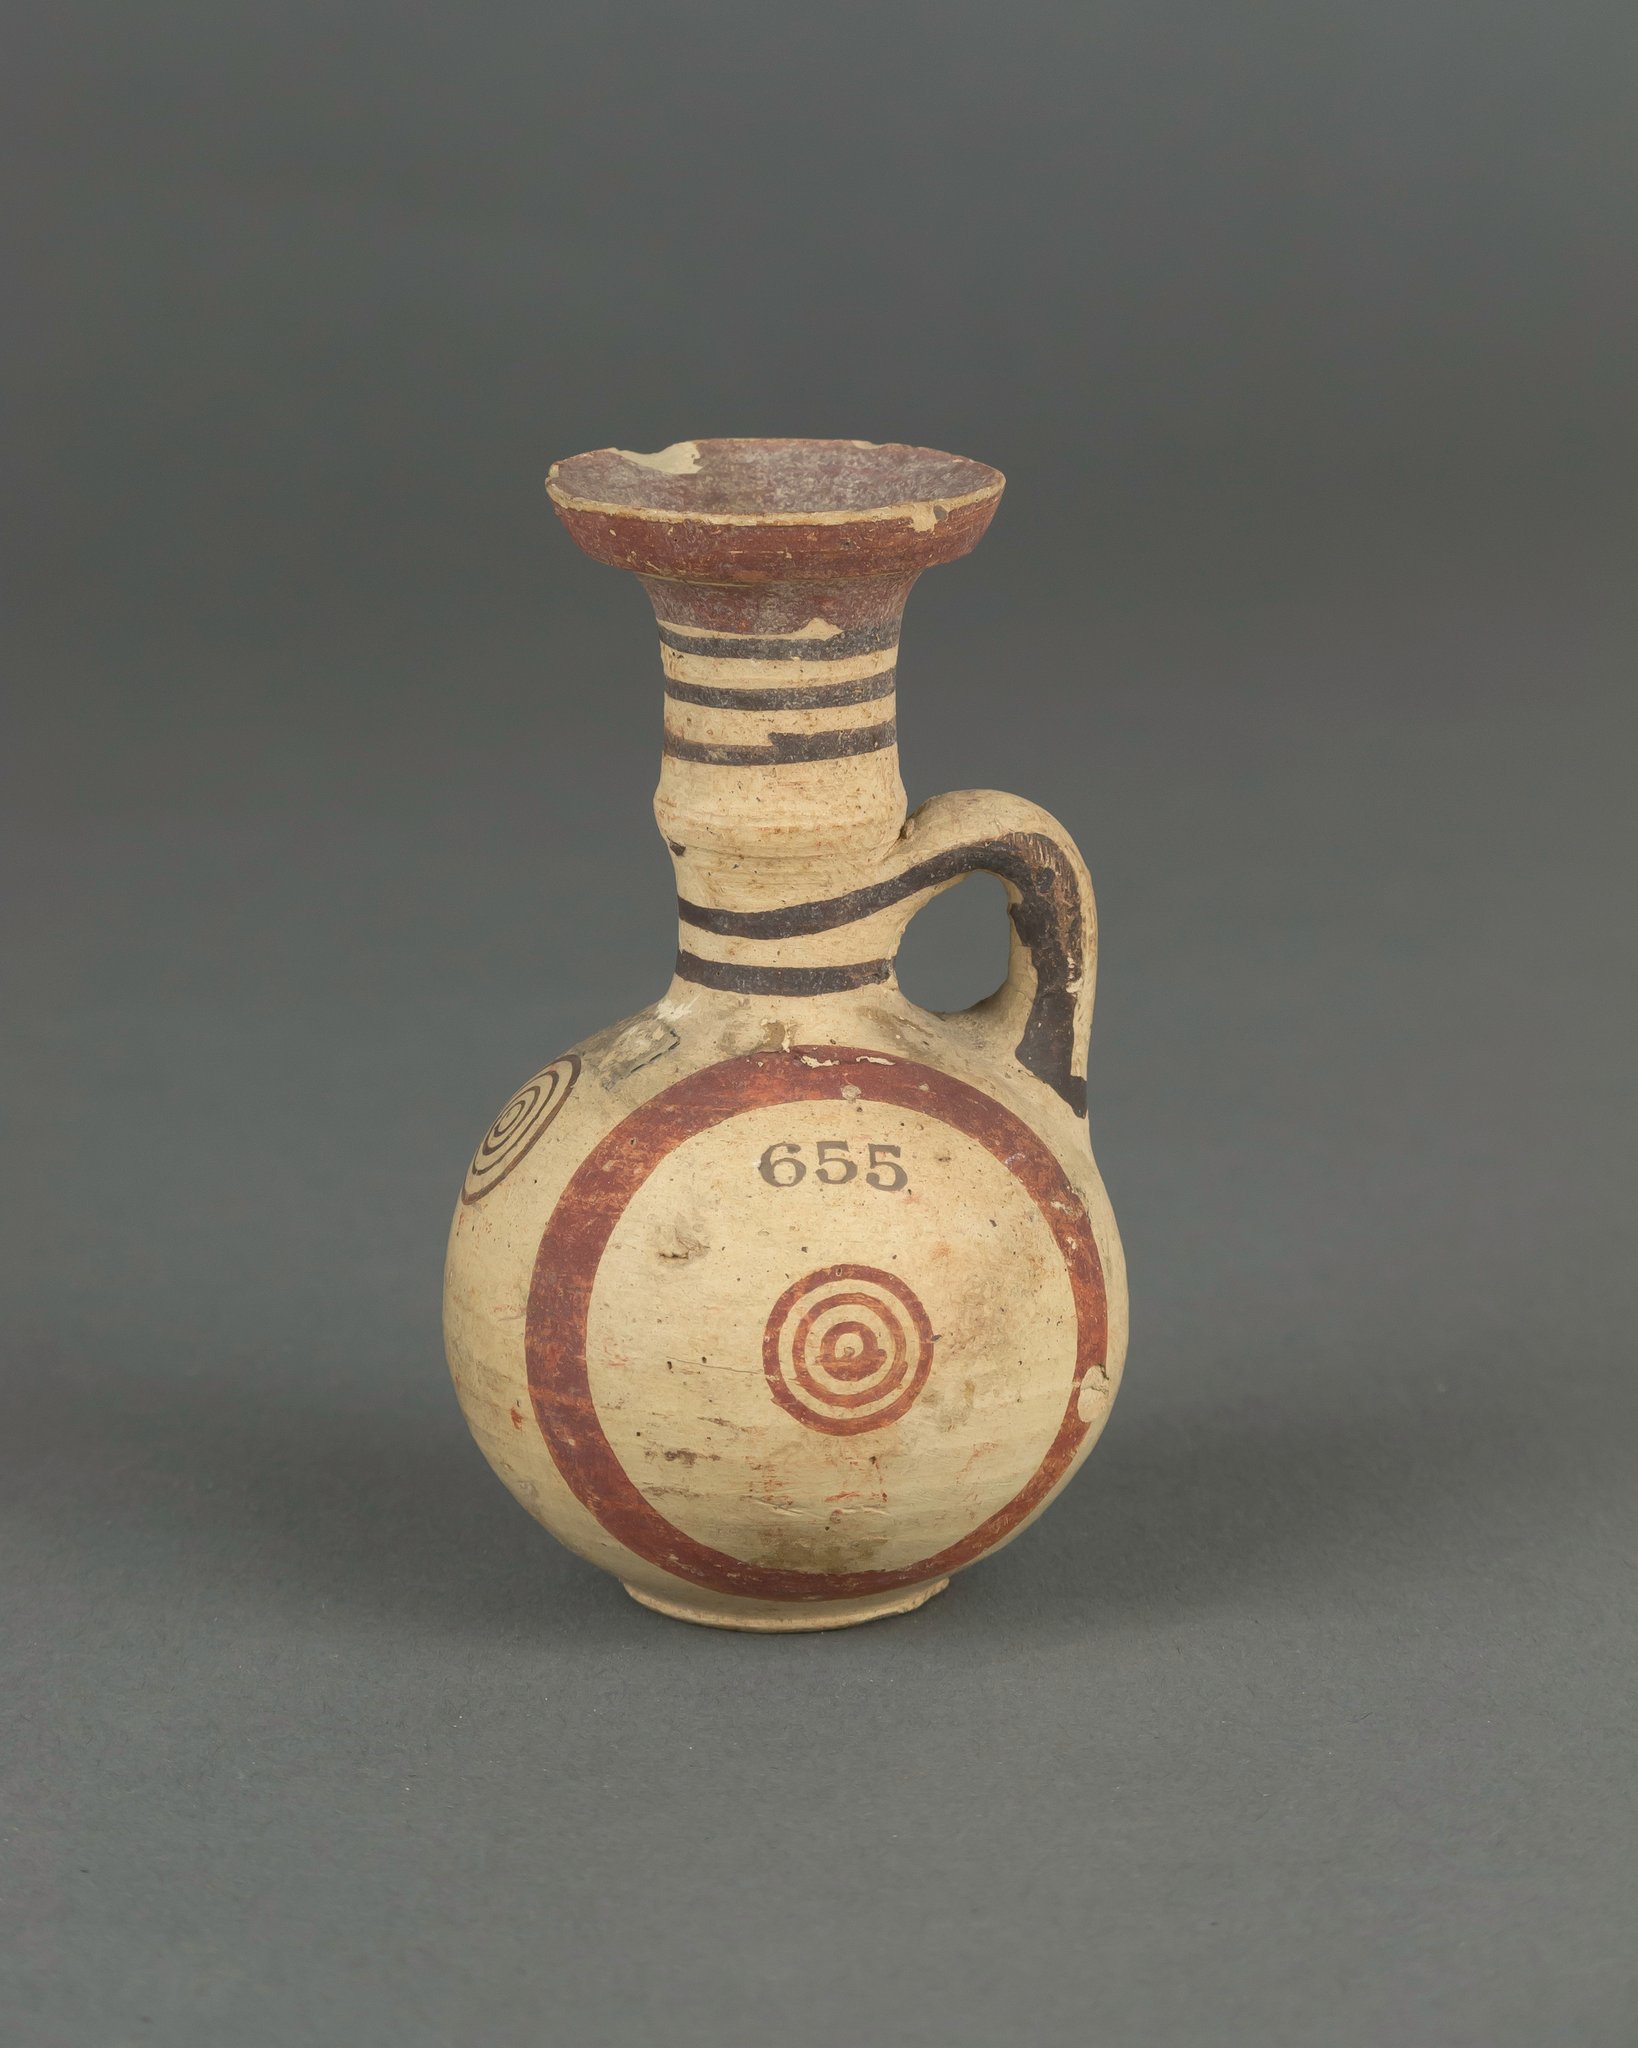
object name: juglet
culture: cypriot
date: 750-600 BCE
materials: terracotta